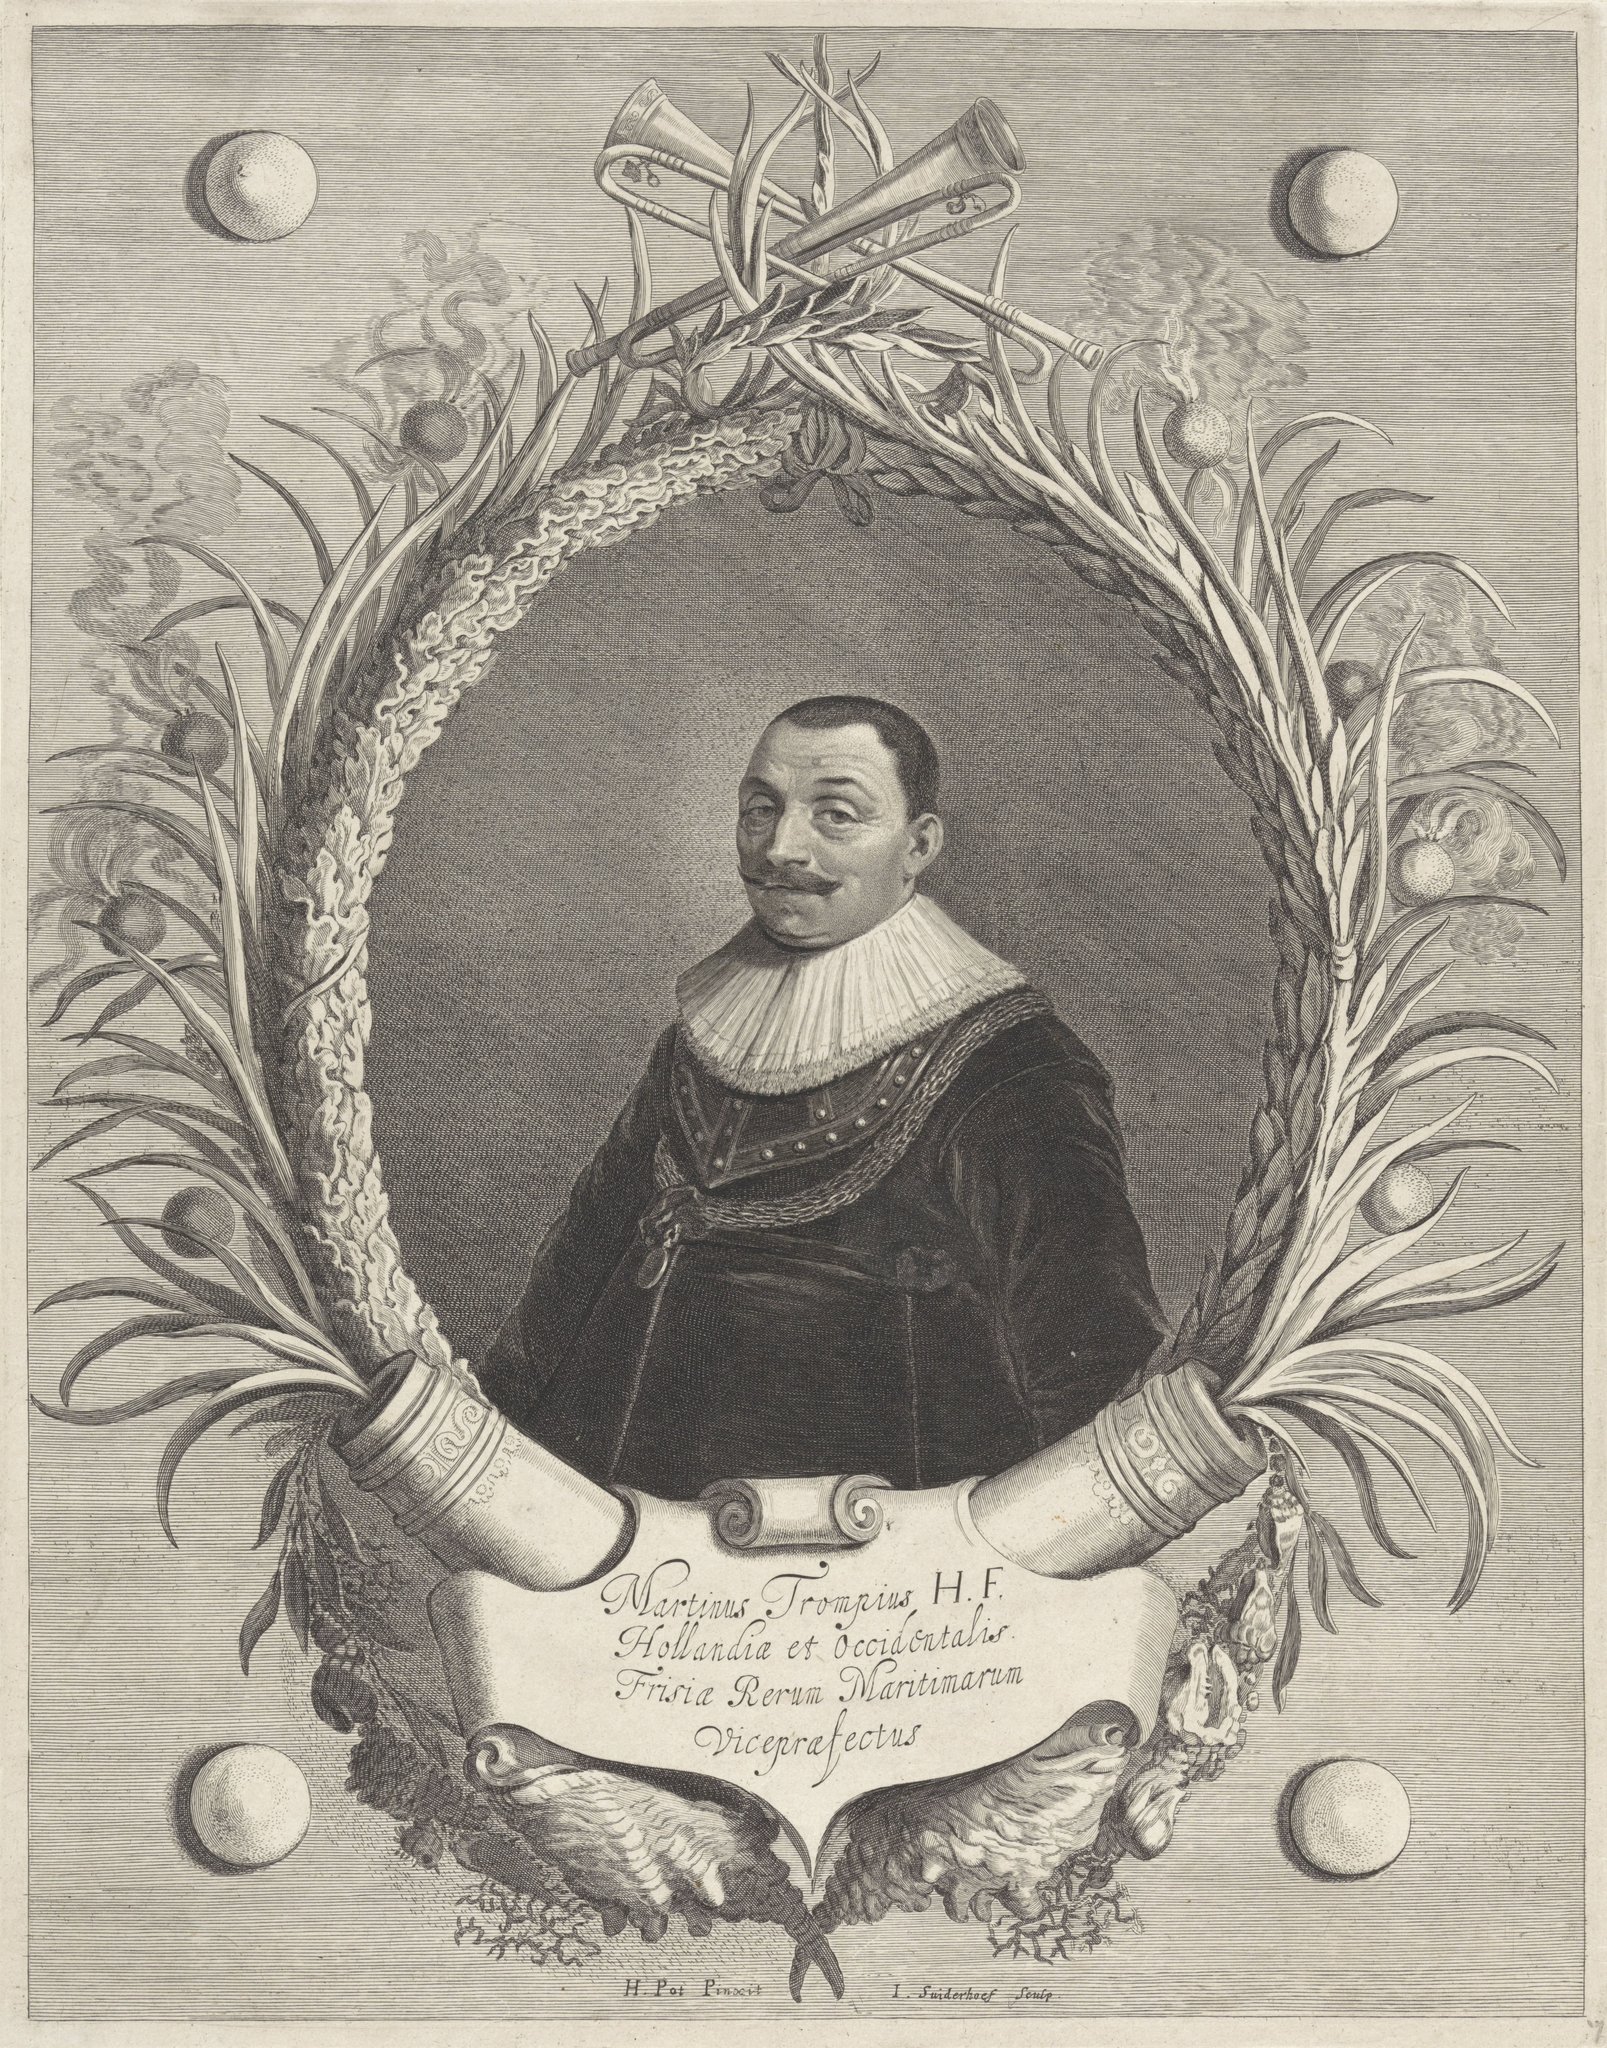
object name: print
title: Portret van Maarten Harpertszoon Tromp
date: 1623-1686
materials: paper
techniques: engraving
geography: haarlem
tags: maarten harpertszoon tromp, historical persons, firearms: cannon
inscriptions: collector's mark: Lugt 240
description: Portret van Maarten Harpertszoon Tromp, luitenant-admiraal van Holland en West-Friesland, in een decoratieve omlijsting van lauwertakken, kanonnen en kanonskogels. De lijst wordt bekroond door twee trompetten.